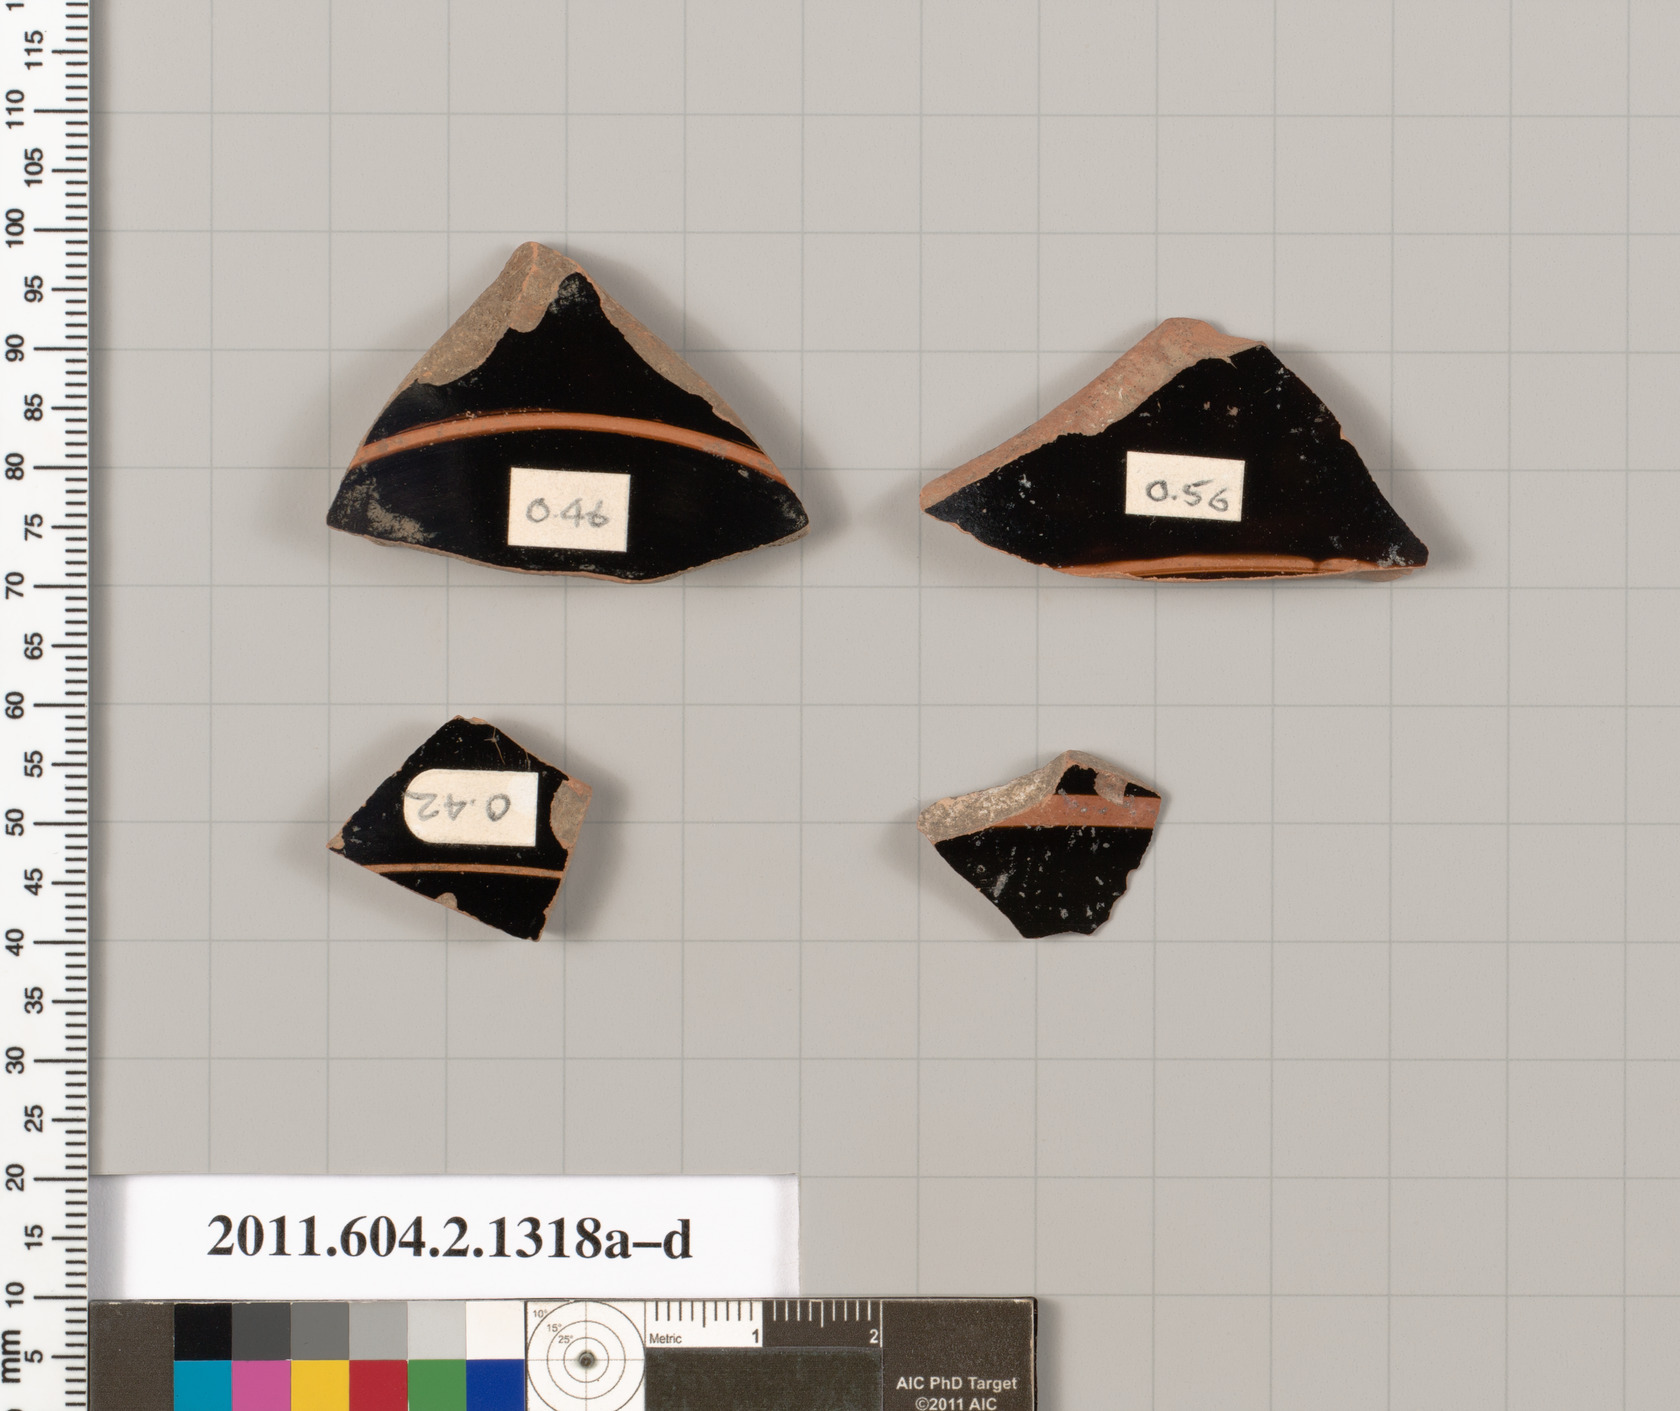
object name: skyphos fragment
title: Terracotta fragments of skyphoi (deep drinking cups)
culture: greek, attic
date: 500-451 BCE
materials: terracotta